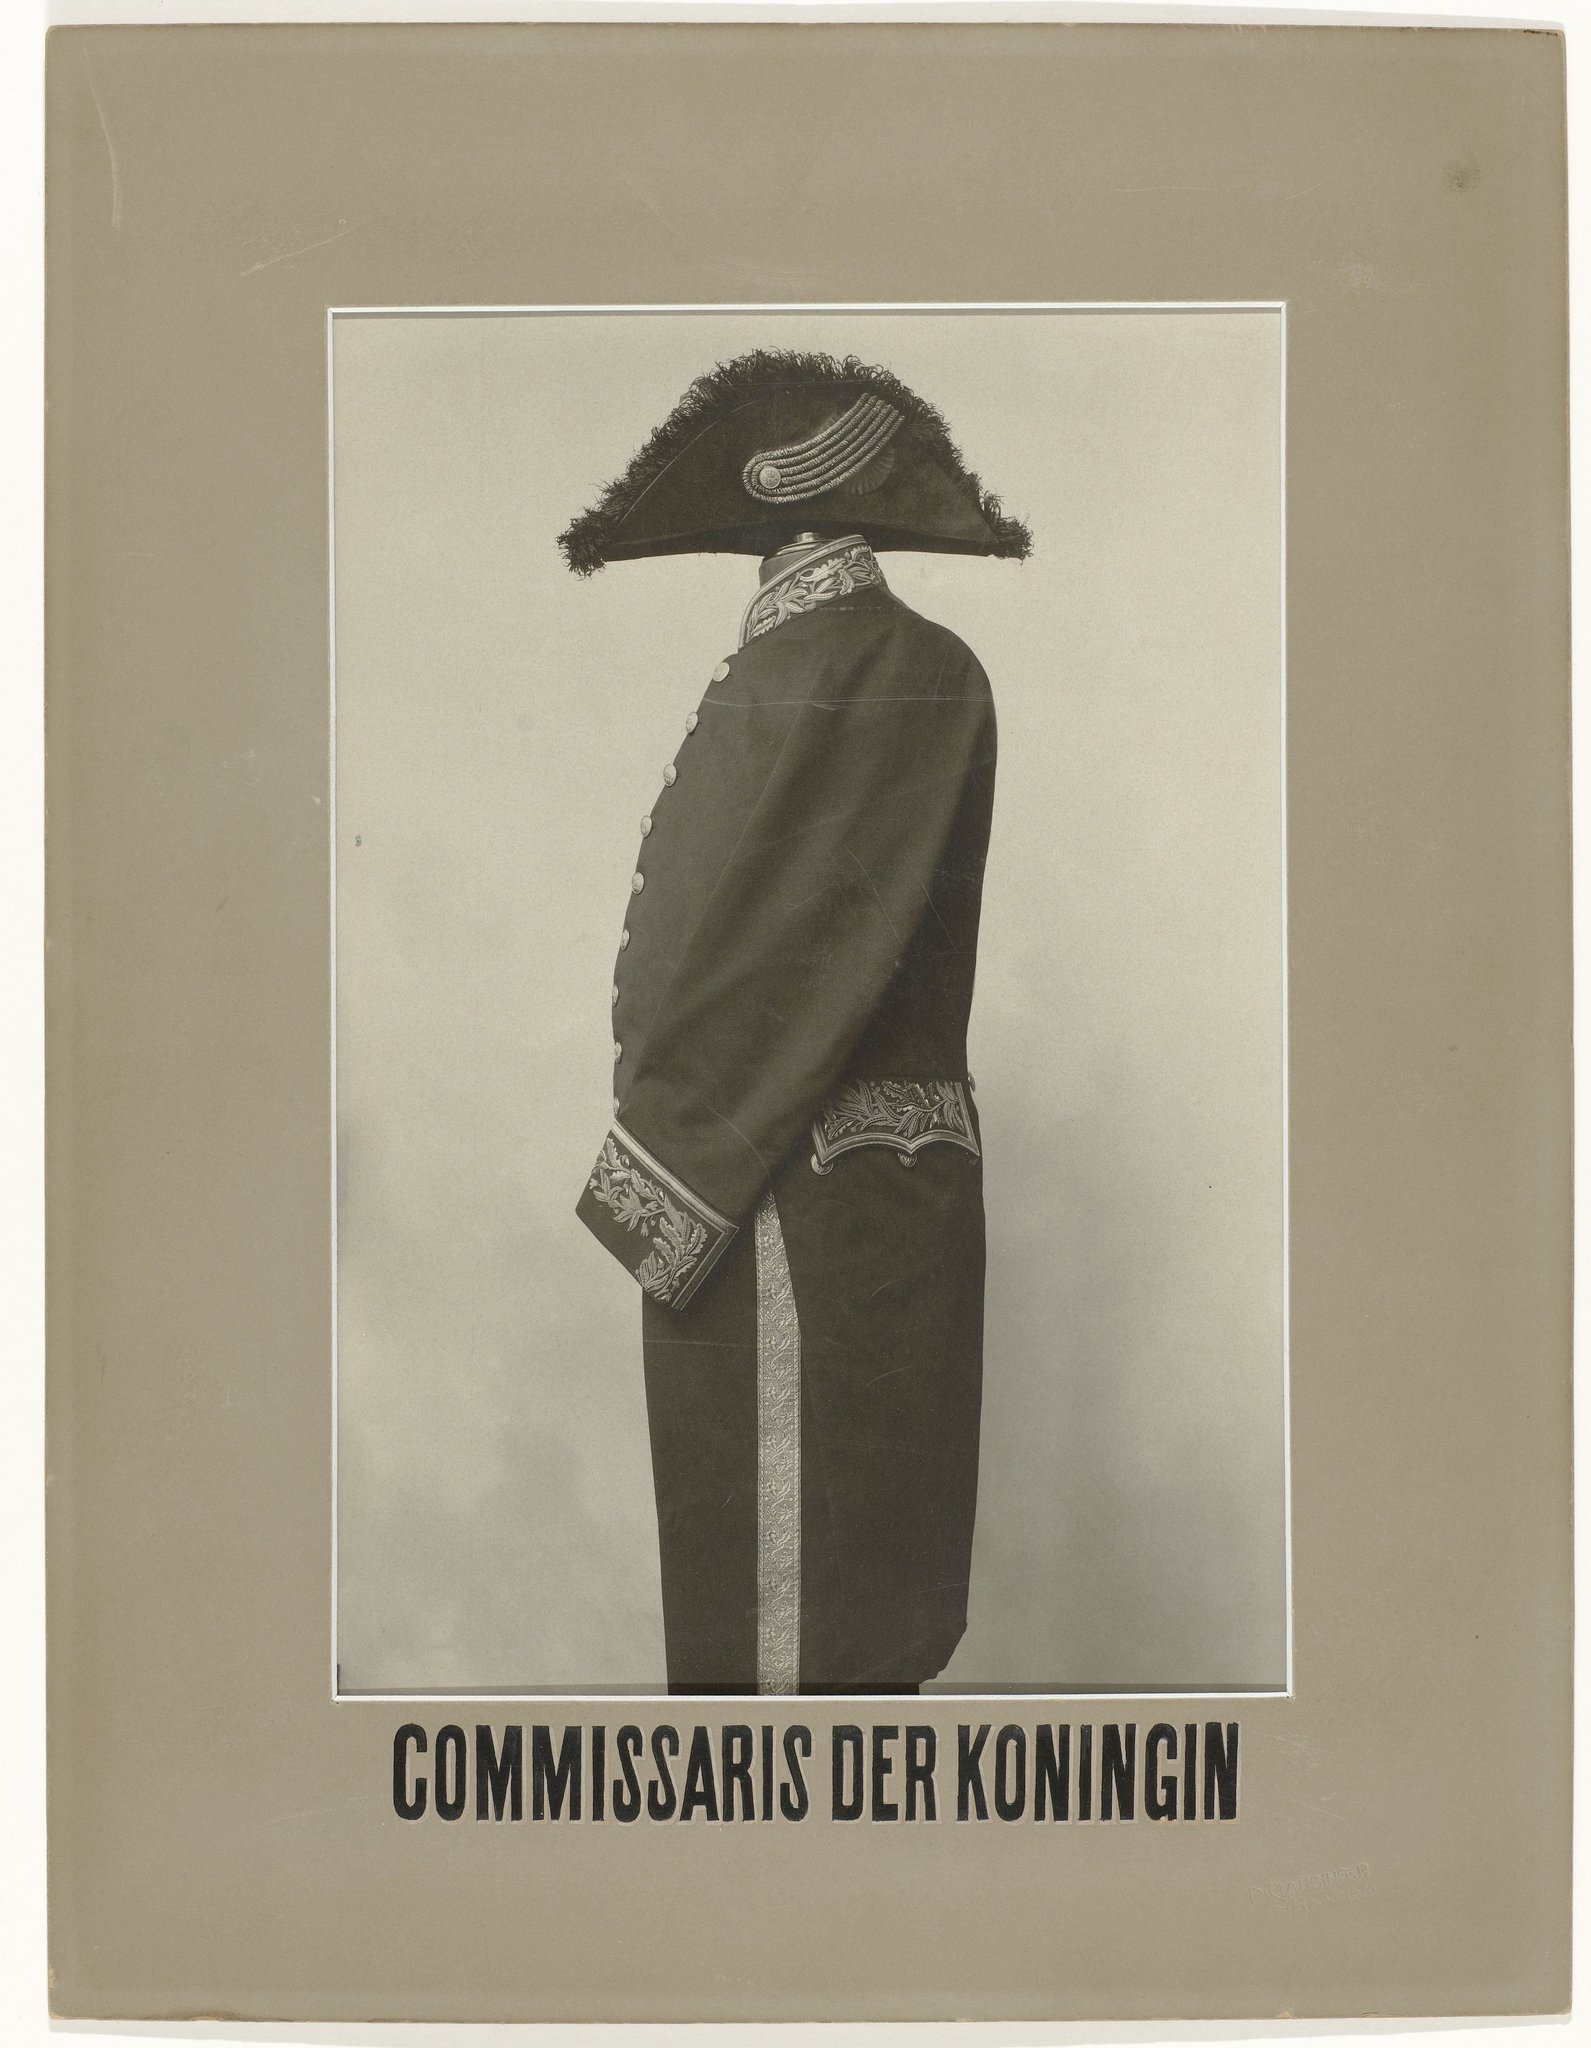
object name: photograph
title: Commissaris der Koningin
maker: peter clausing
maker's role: fotograaf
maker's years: 1870-1913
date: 1875-1900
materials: cardboard, paper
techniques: photography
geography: haarlem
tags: netherlands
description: Eén van acht foto's van ambtskostuums, in grijsbruin passe-partout met onder benaming in verf, kapitalen, zwarte letter met witte 'schaduw'. Onderschrift: COMMISSARIS DER KONINGIN. Gemerkt; r.o.: reliëfstempel: 'P. Clausing jr / Haarlem'. Opmerking: zie NG-1029-A t/m H.